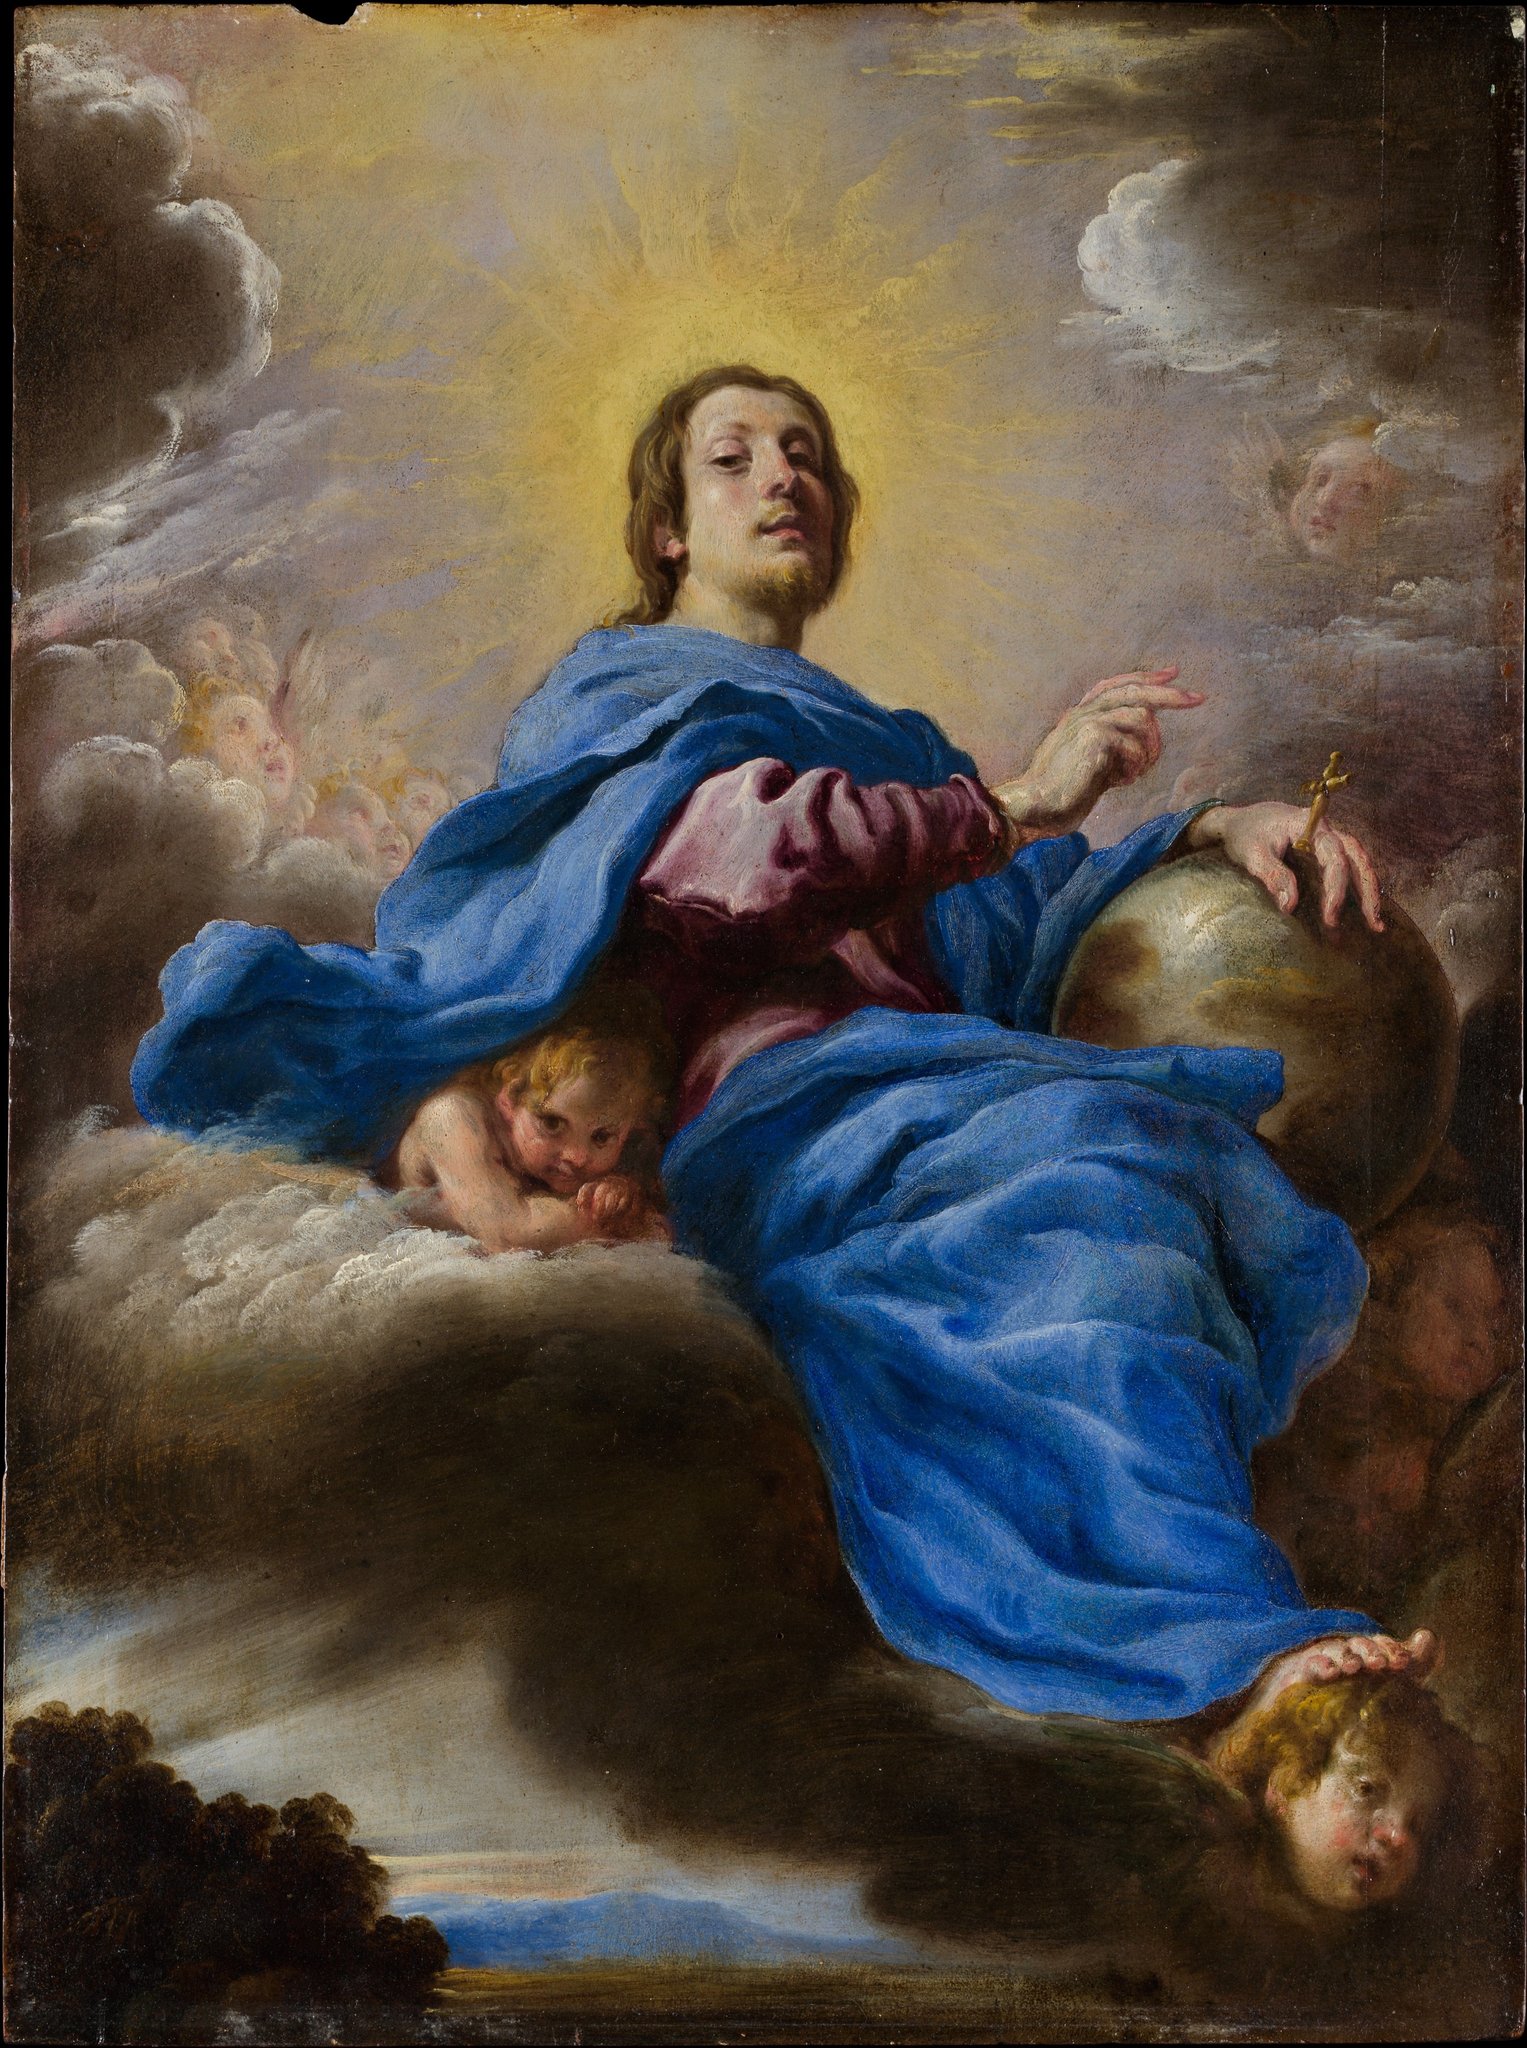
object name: painting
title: Salvator Mundi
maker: domenico fetti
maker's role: artist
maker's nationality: italian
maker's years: 1591-1623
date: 1622-1623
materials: oil, wood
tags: putti,clouds,christ